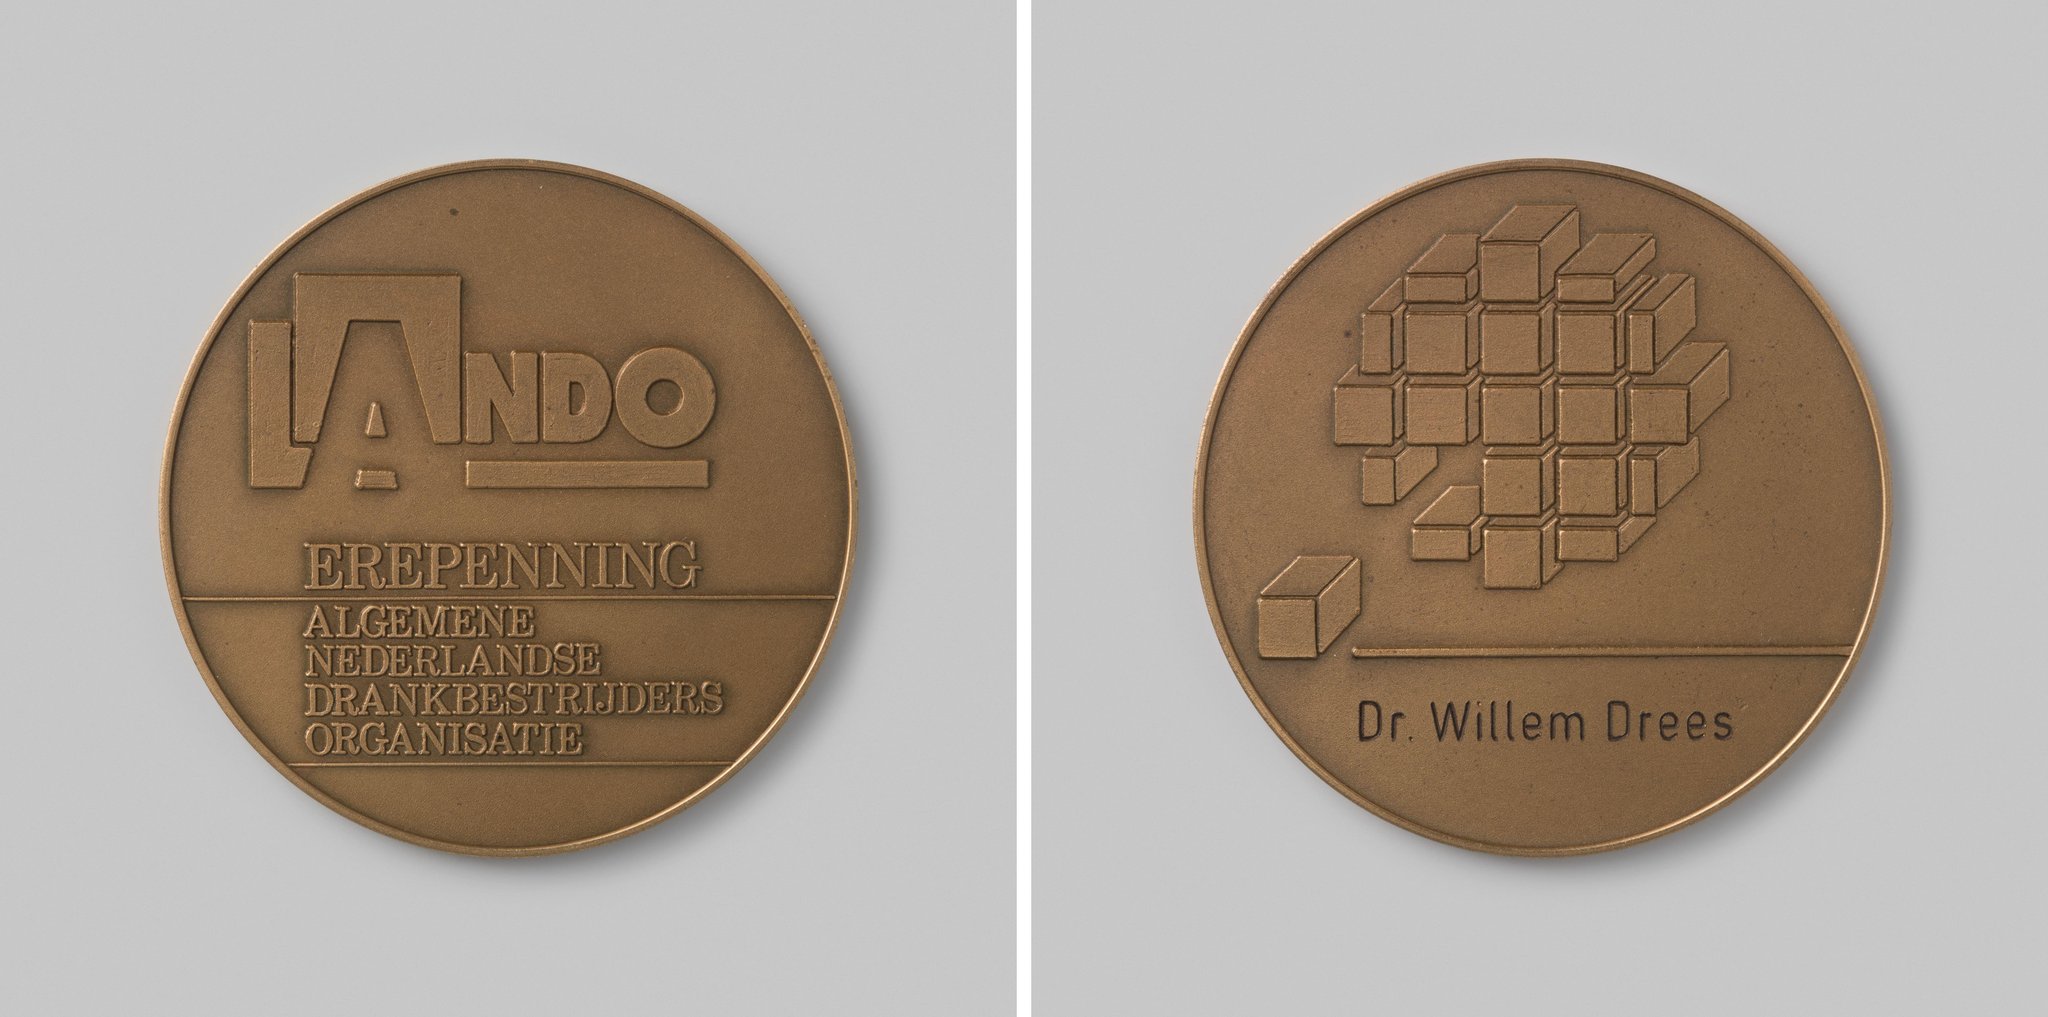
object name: honorary medal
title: Algemene Nederlandse Drankbestrijdersorganisatie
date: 1960-1990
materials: brass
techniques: engraving, striking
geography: voorschoten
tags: amsterdam, the hague, willem drees, netherlands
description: Messing penning met op de voorzijde in gestileerde letters opschrift: ANDO; EREPENNING / ALGEMENE / NEDERLANDSE / DRANKBESTRIJDERS ORGANISATIE. Keerzijde: centraal: cirkel opgebouwd uit kubussen. Links onder is een kubus uit de cirkel naar voren geplaatst. Op afsnede is opschrift gegraveerd: Dr. Willem Drees. Bij de penning is vierkant blauw plastic doosje.